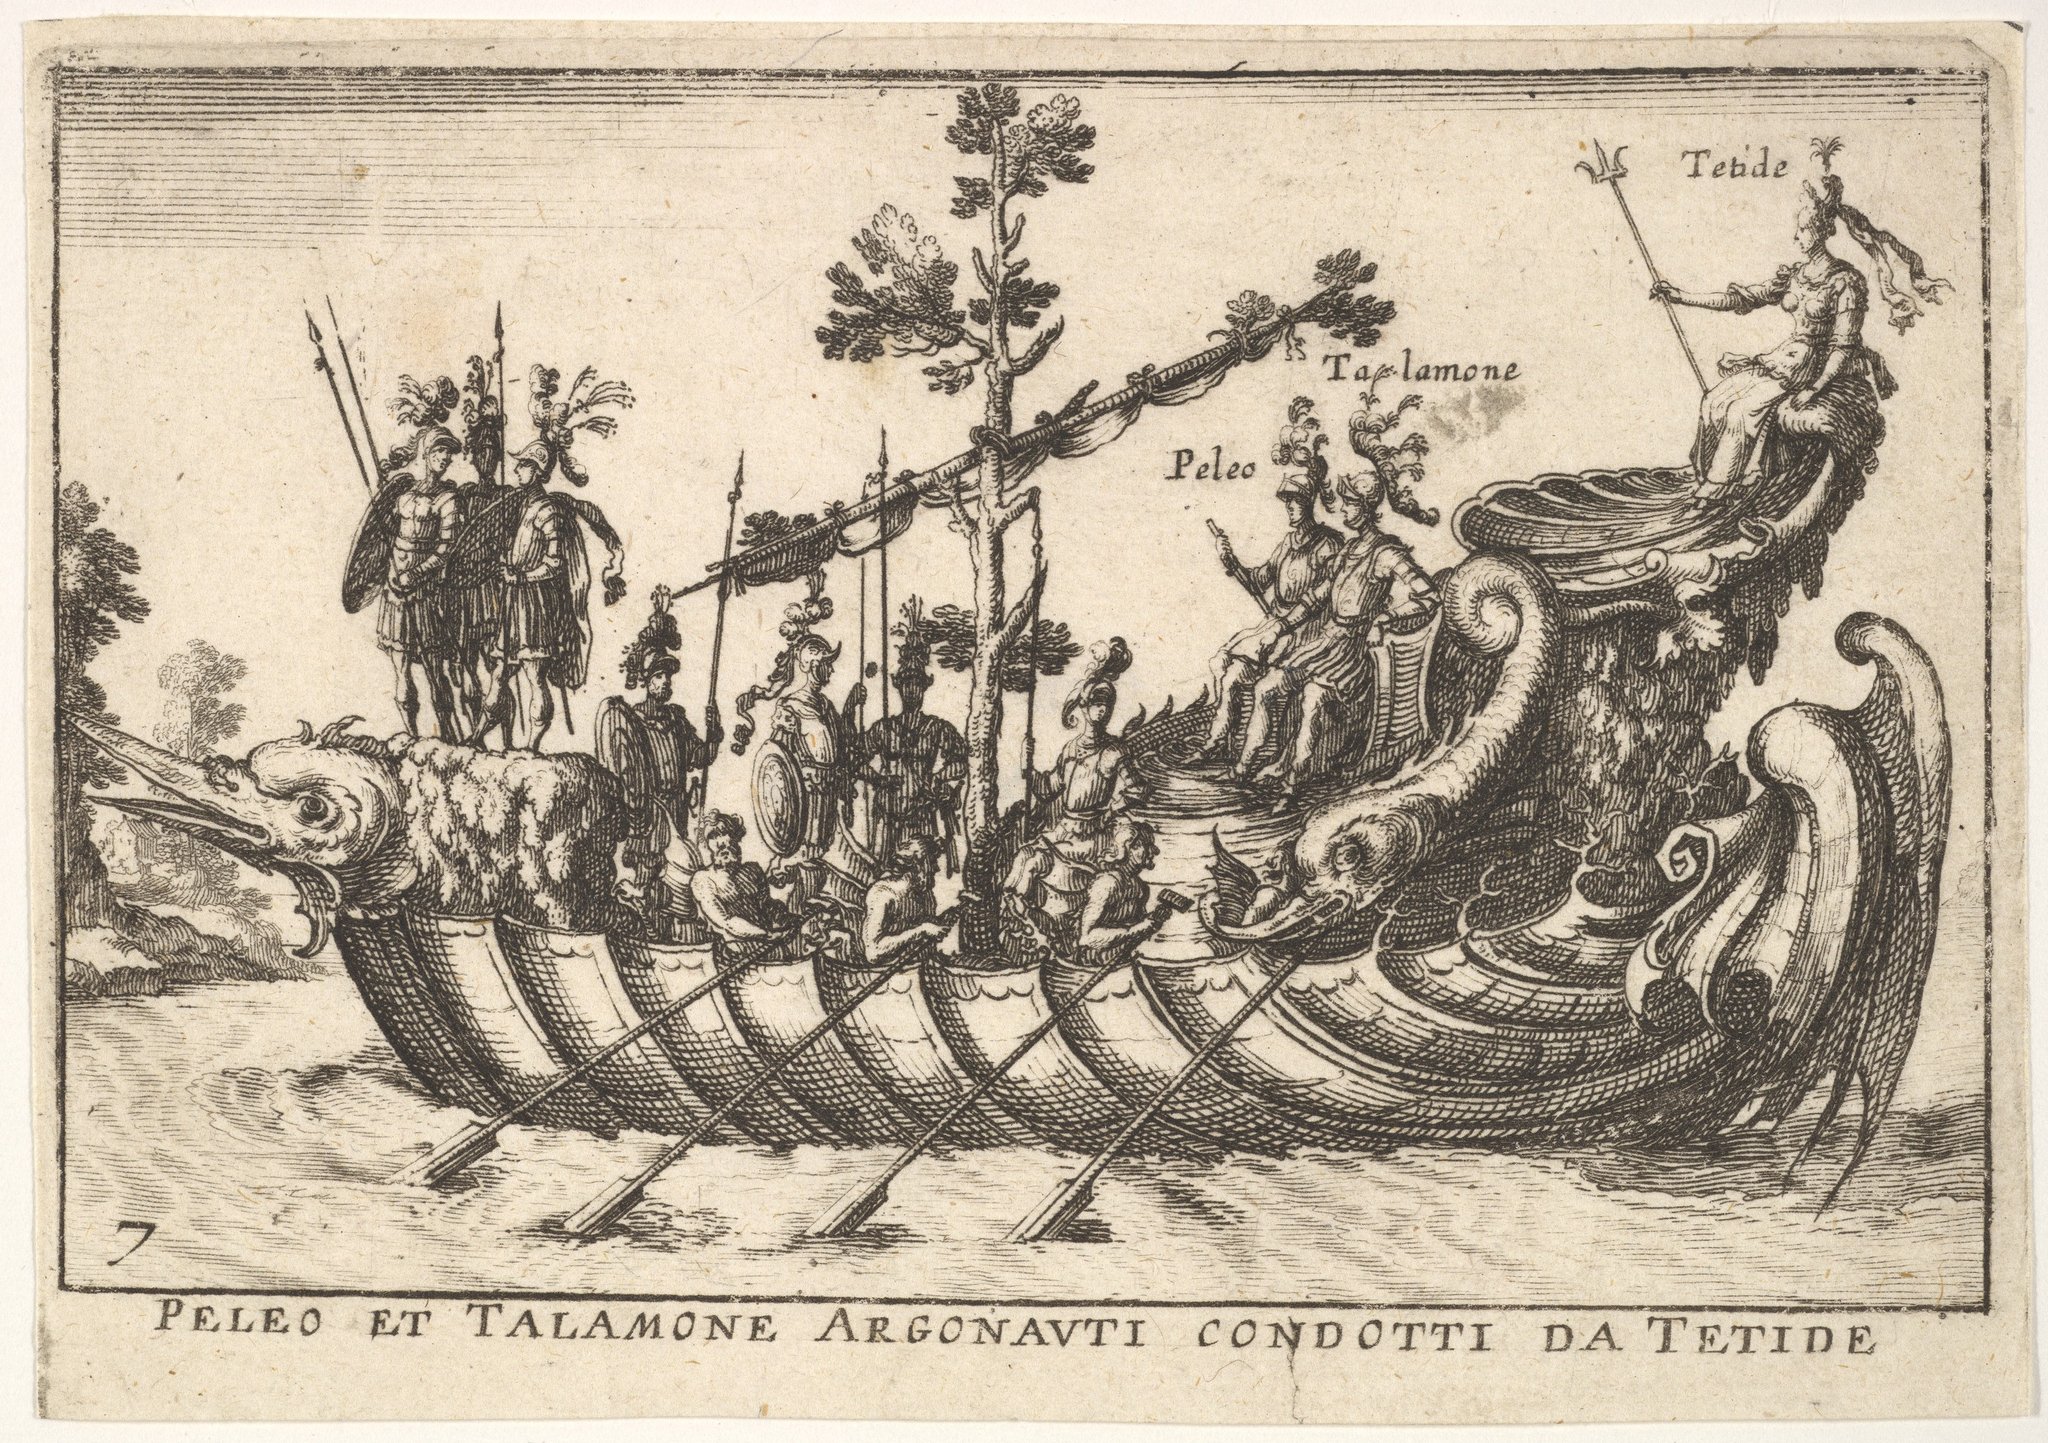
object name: print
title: Plate 7: Peleo et Talamone Argonauti condotti da Tetide, from "The magnificent pageant on the river Arno in Florence for the marriage of the Grand Duke" (Le Magnifique carousel fait sur le fleuve de l'Arne a Florence, pour le mariage du Grand Duc)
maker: Anonymous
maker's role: artist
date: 1664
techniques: etching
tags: soldiers,men,rivers,trees,ships